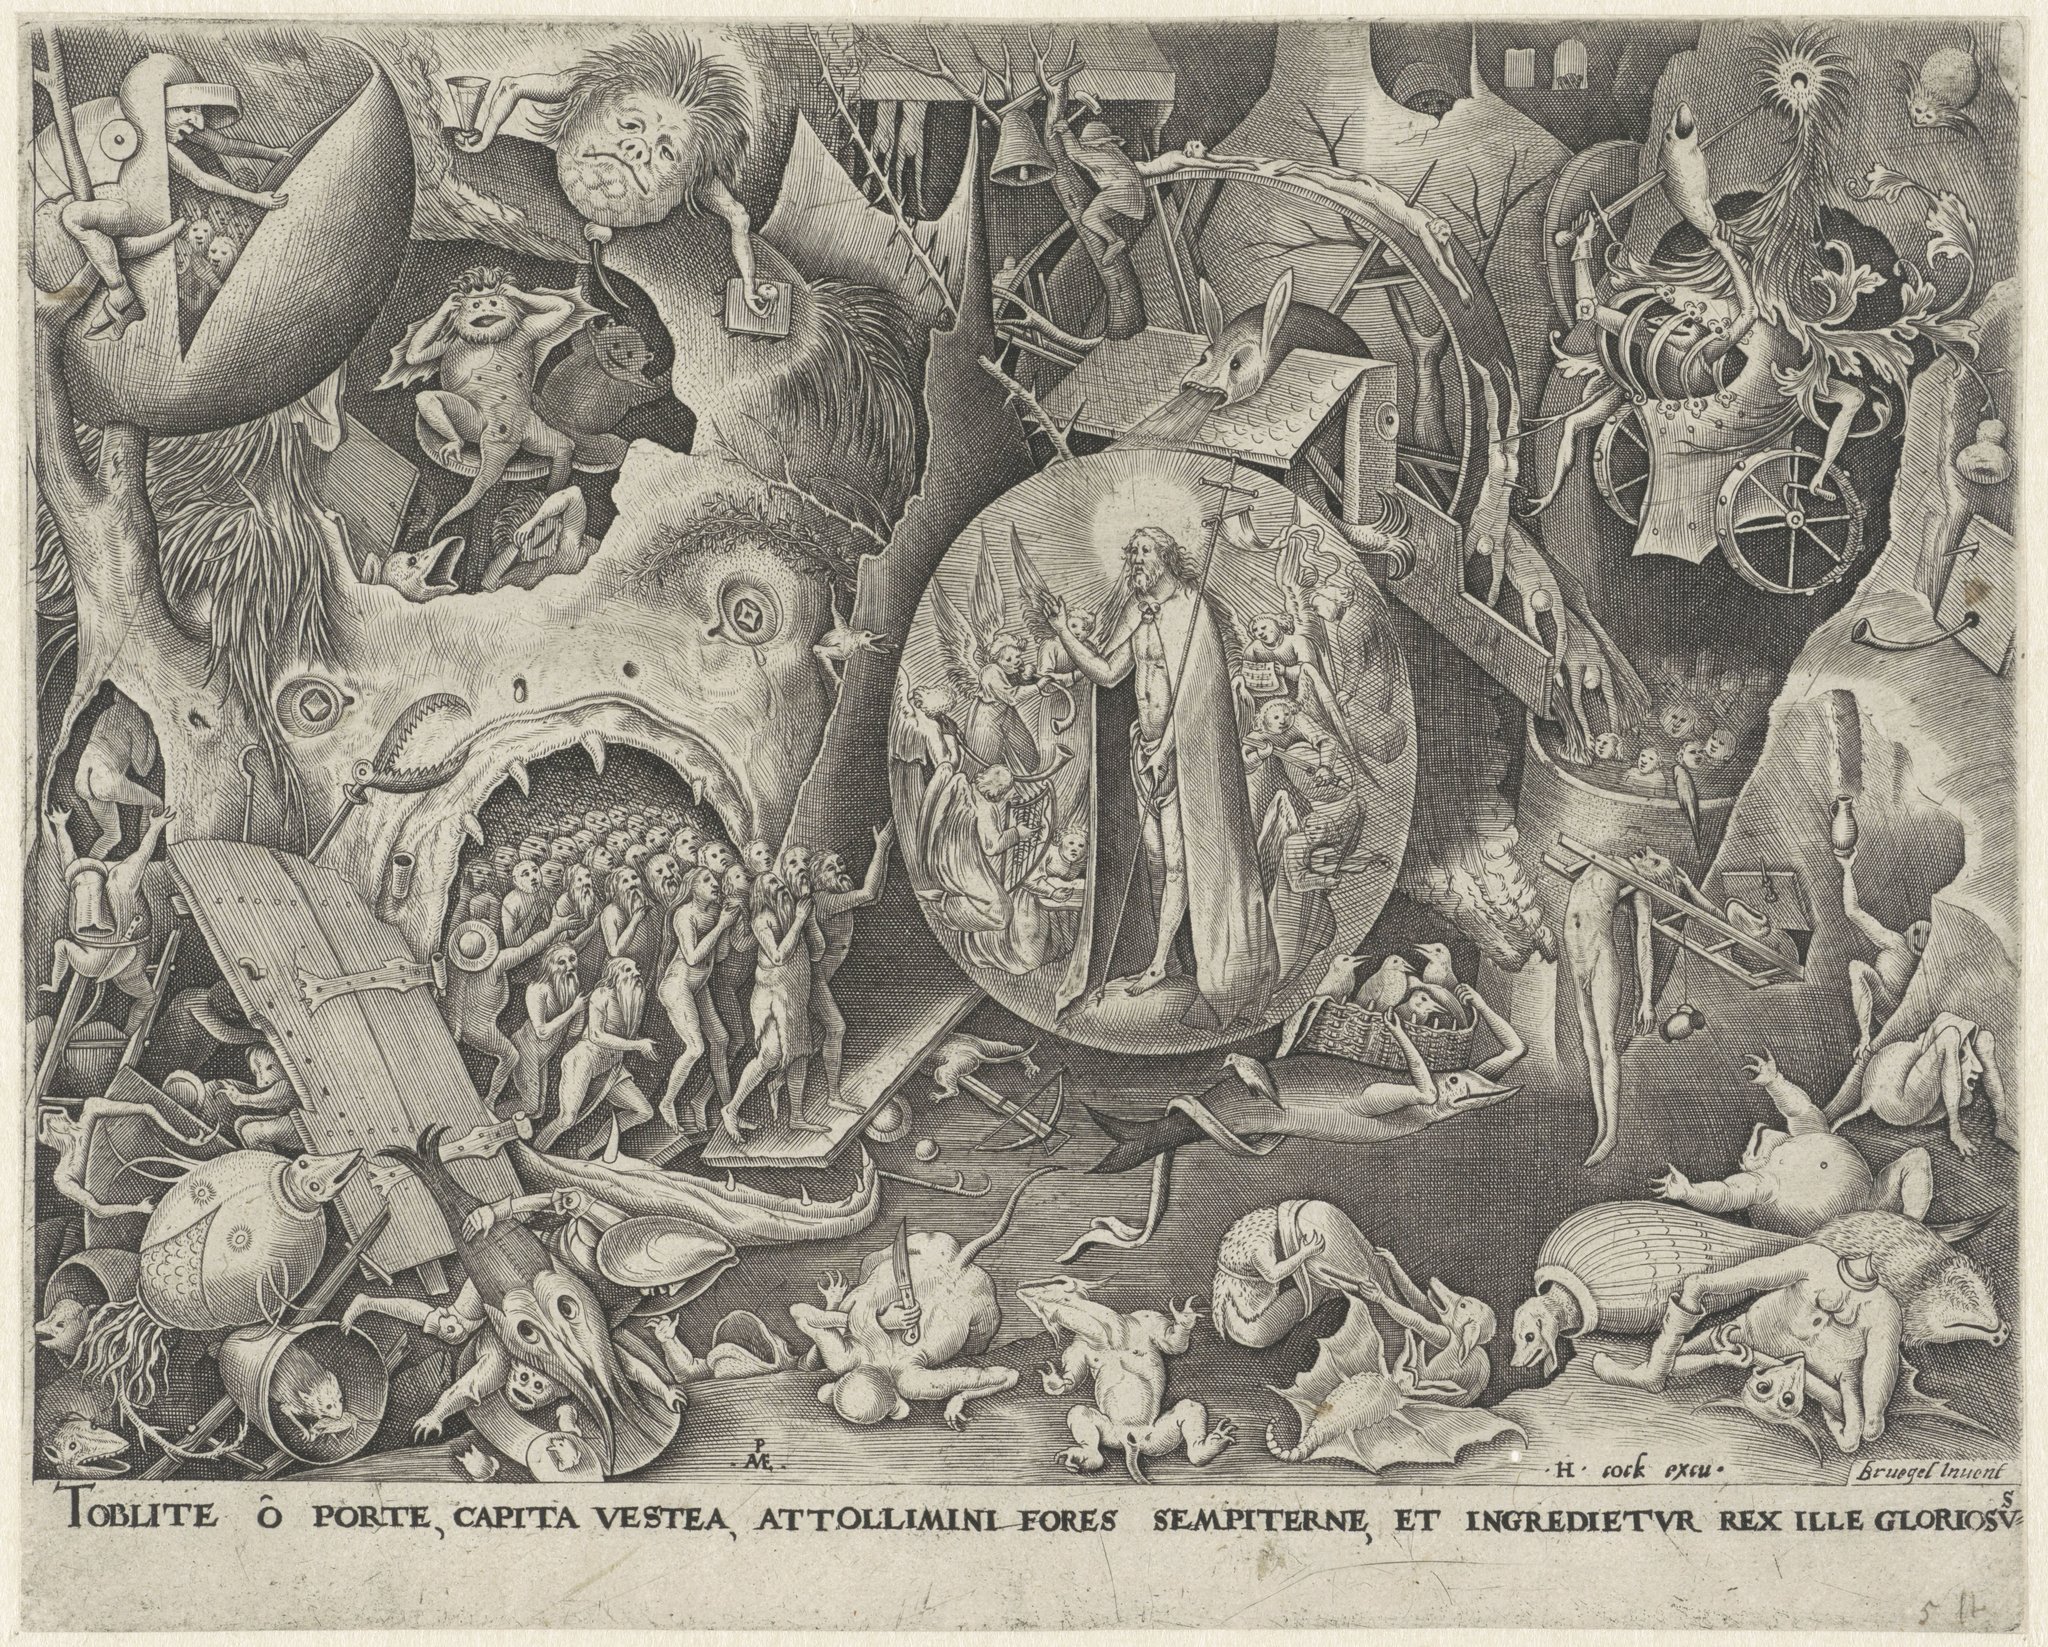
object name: print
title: Christus in het voorgeborchte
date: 1559-1563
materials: paper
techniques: engraving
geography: antwerp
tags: christ in the underworld, harrowing of hell, christ in limbo, 'descensus ad inferos', 'anastasis'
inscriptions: collector's mark: Lugt 2228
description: Christus daalt af in het voorgeborchte van de hel vergezeld door engelen. Hij redt de zielen uit de hellemond links. Rondom duivels, demonen en monsters. Onder de voorstelling een regel tekst in het Latijn.